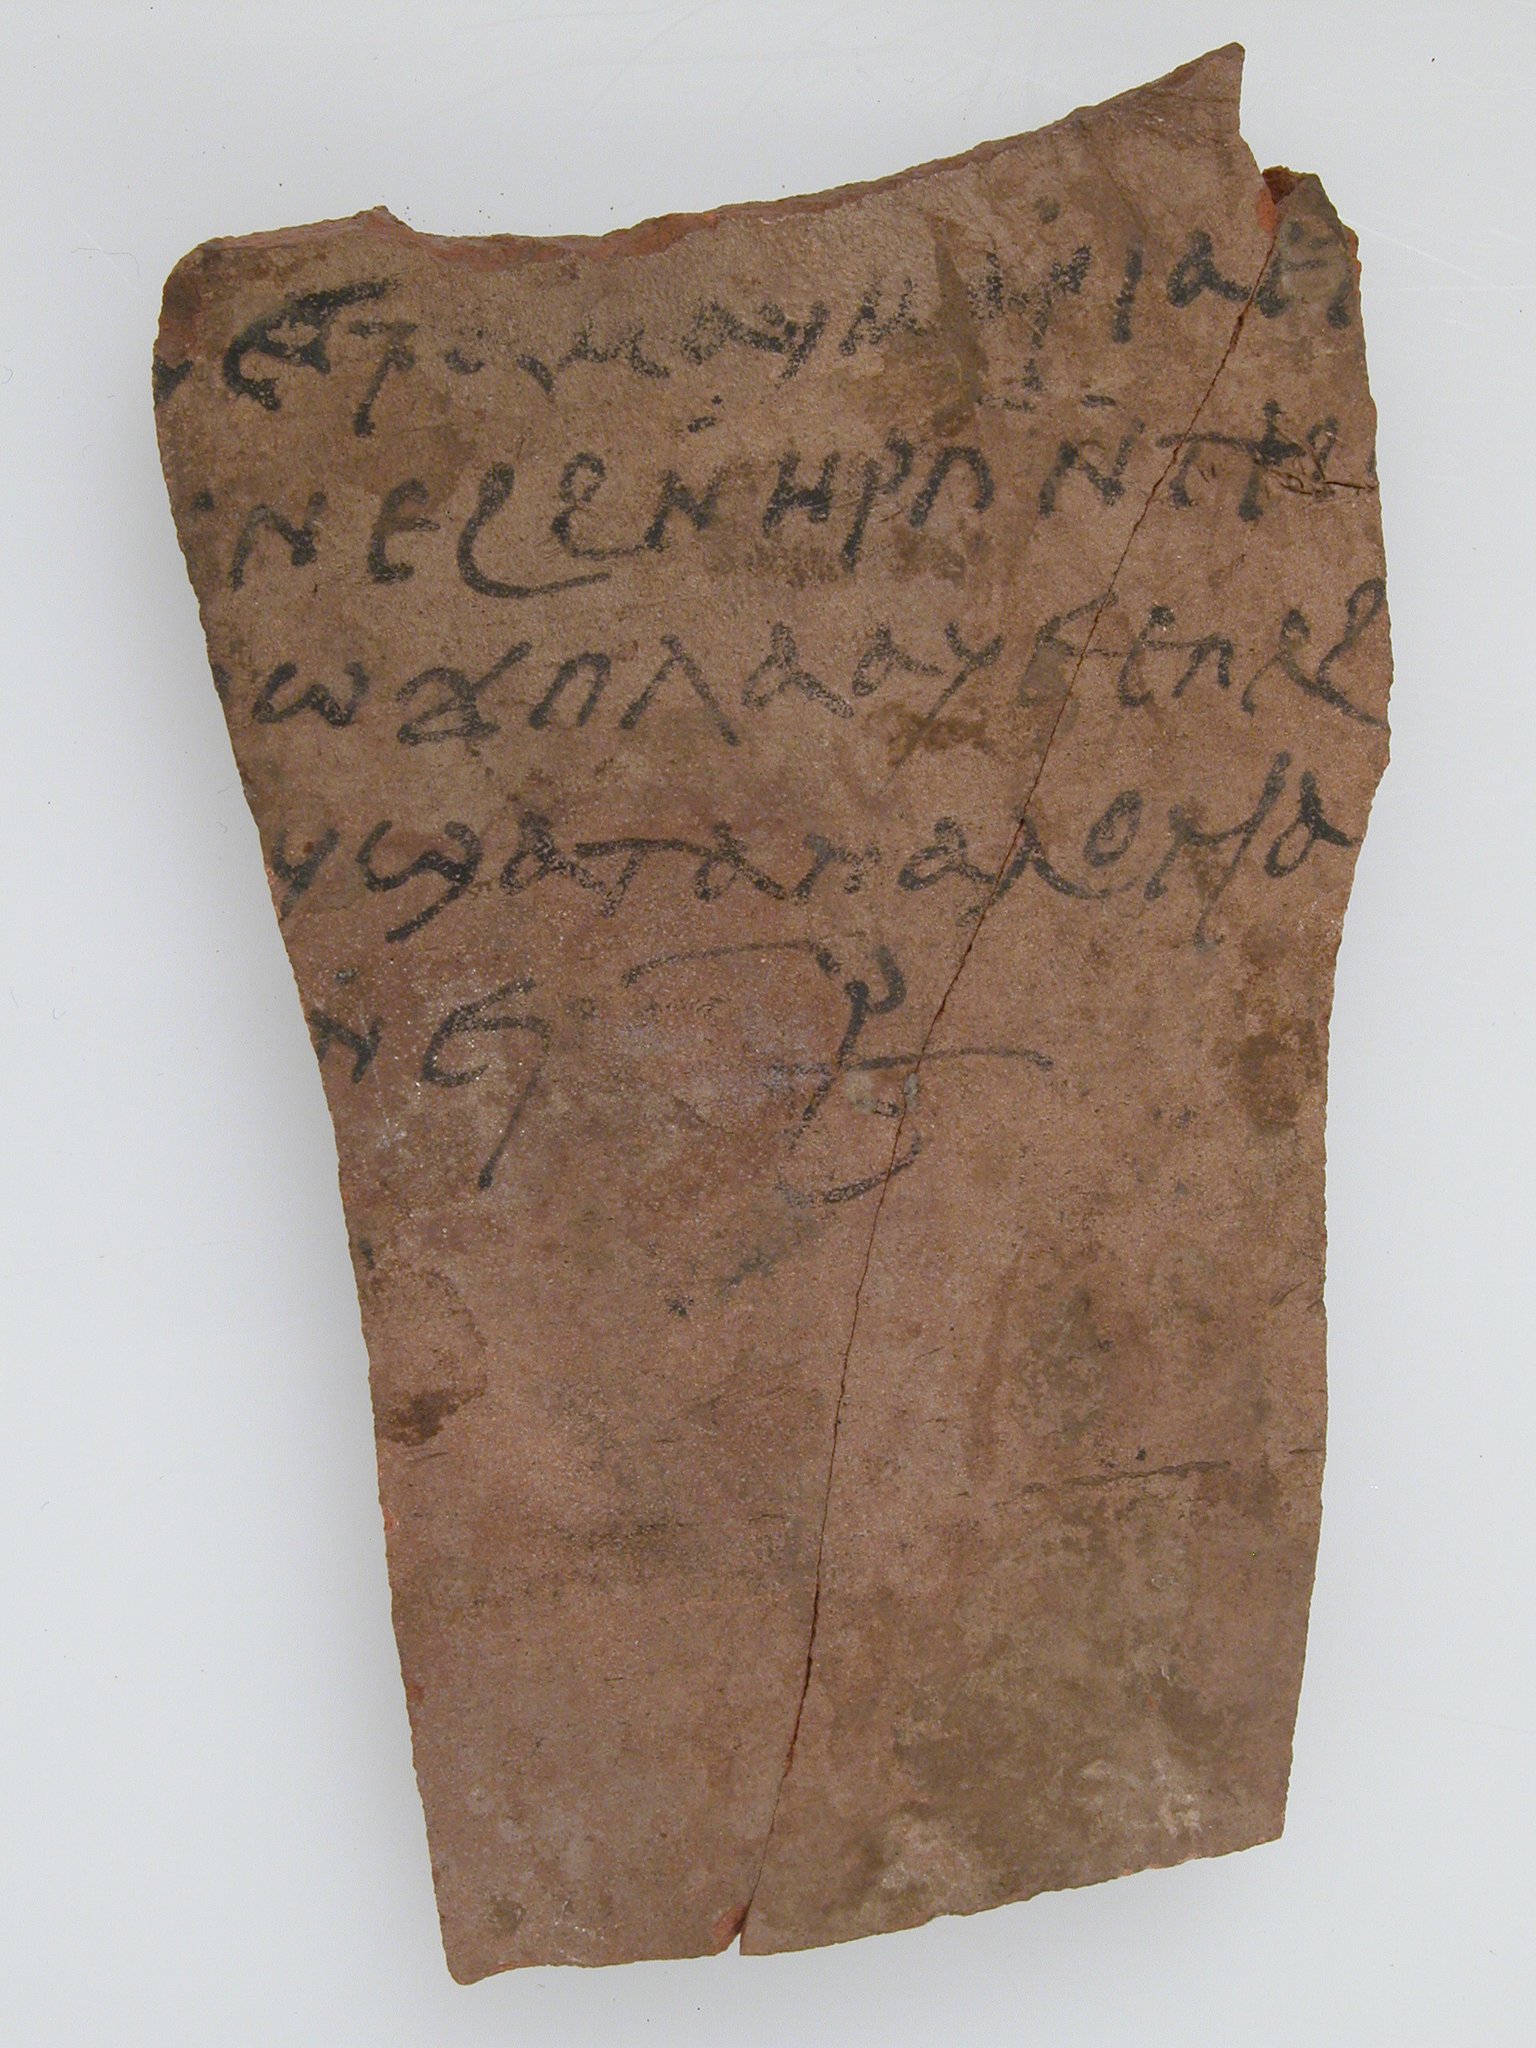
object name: ostrakon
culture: coptic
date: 601-700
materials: ink, pottery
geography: egypt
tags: coptic